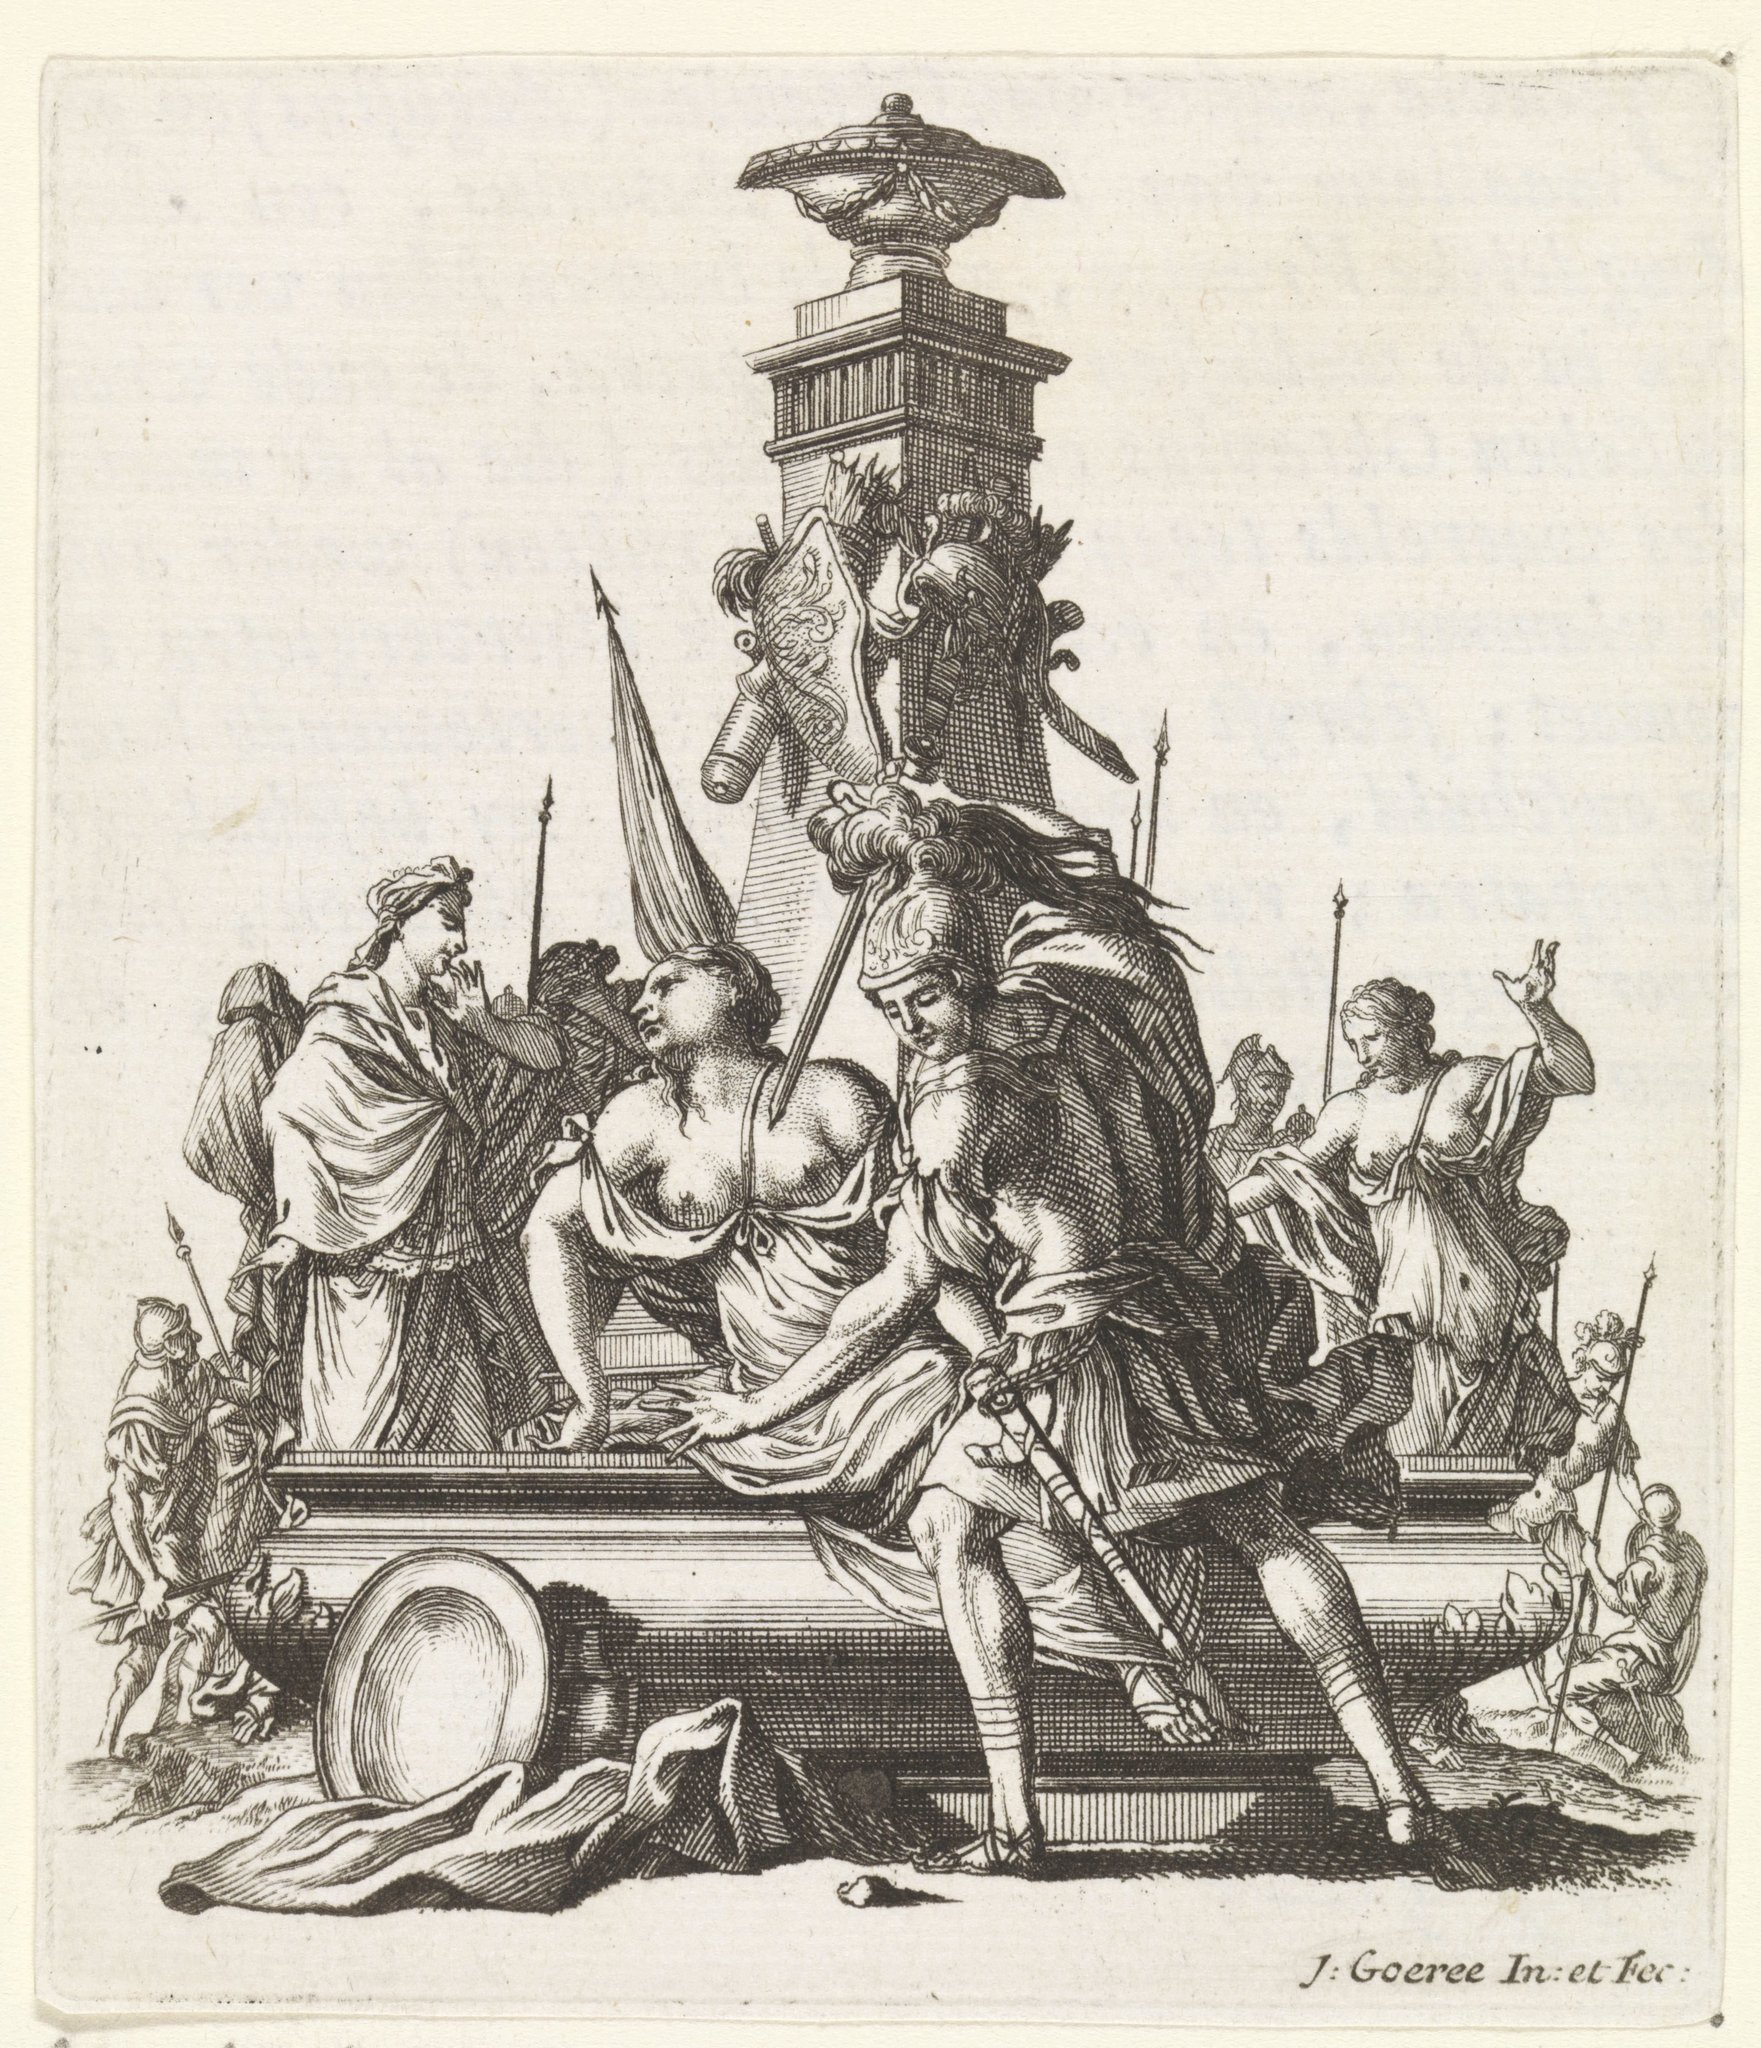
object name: print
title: Offer van Polyxena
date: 1710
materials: paper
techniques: engraving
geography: amsterdam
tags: polyxena is sacrificed by neoptolemus on achilles' tomb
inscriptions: collector's mark: Lugt 2228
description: Boekillustratie voor Jan Baptista Wellekens and Pieter Vlaming, "Dichtlievende Uitspanningen". Amsterdam bij A. van Damme, 1710, p. 143.